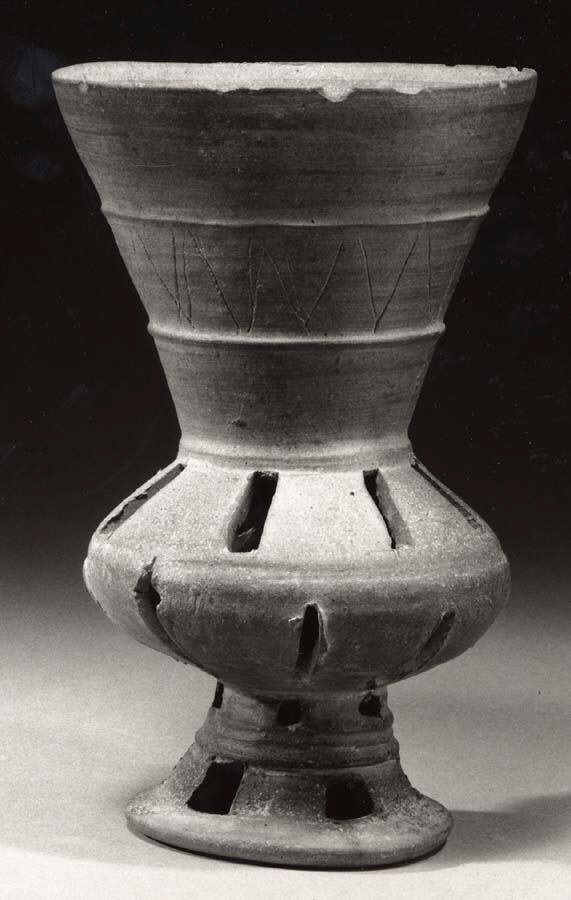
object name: cup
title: Bell cup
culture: korean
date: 401-600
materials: stoneware